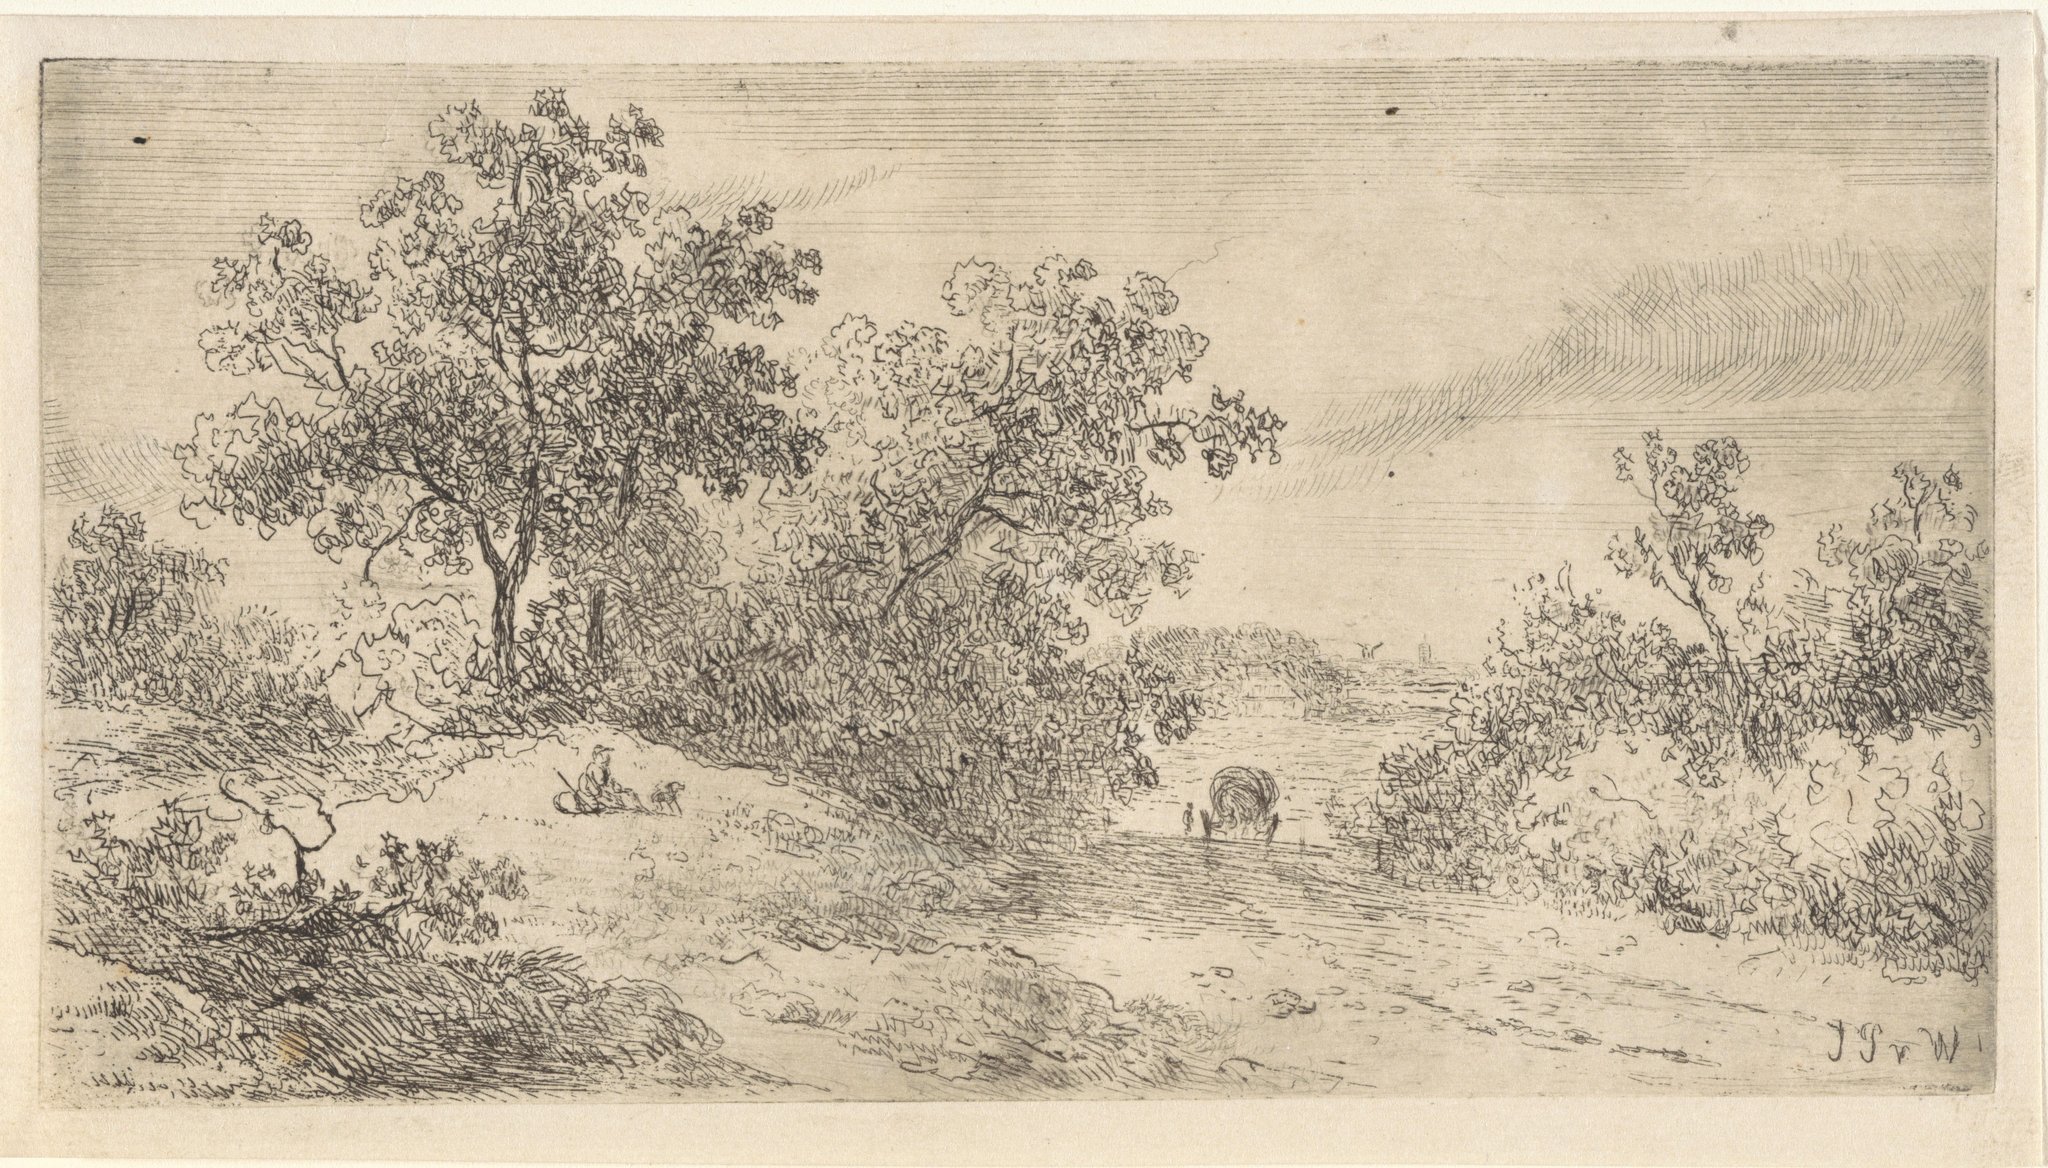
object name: print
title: Rustende jager langs een landweg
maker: johannes pieter van wisselingh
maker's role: draughtsman, painter, print maker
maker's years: 1812-1899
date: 1830-1878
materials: paper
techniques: etching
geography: netherlands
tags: hunter, road, path, resting - bb - out of doors, dog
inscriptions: collector's mark: Lugt 2228, name: ‘Wesseling’, collector's mark: Lugt 1485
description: Rechts een paard-en-wagen op een landweg. Links een rustende jager met een hond op een open plek. In de verte een molen en een kerktoren.